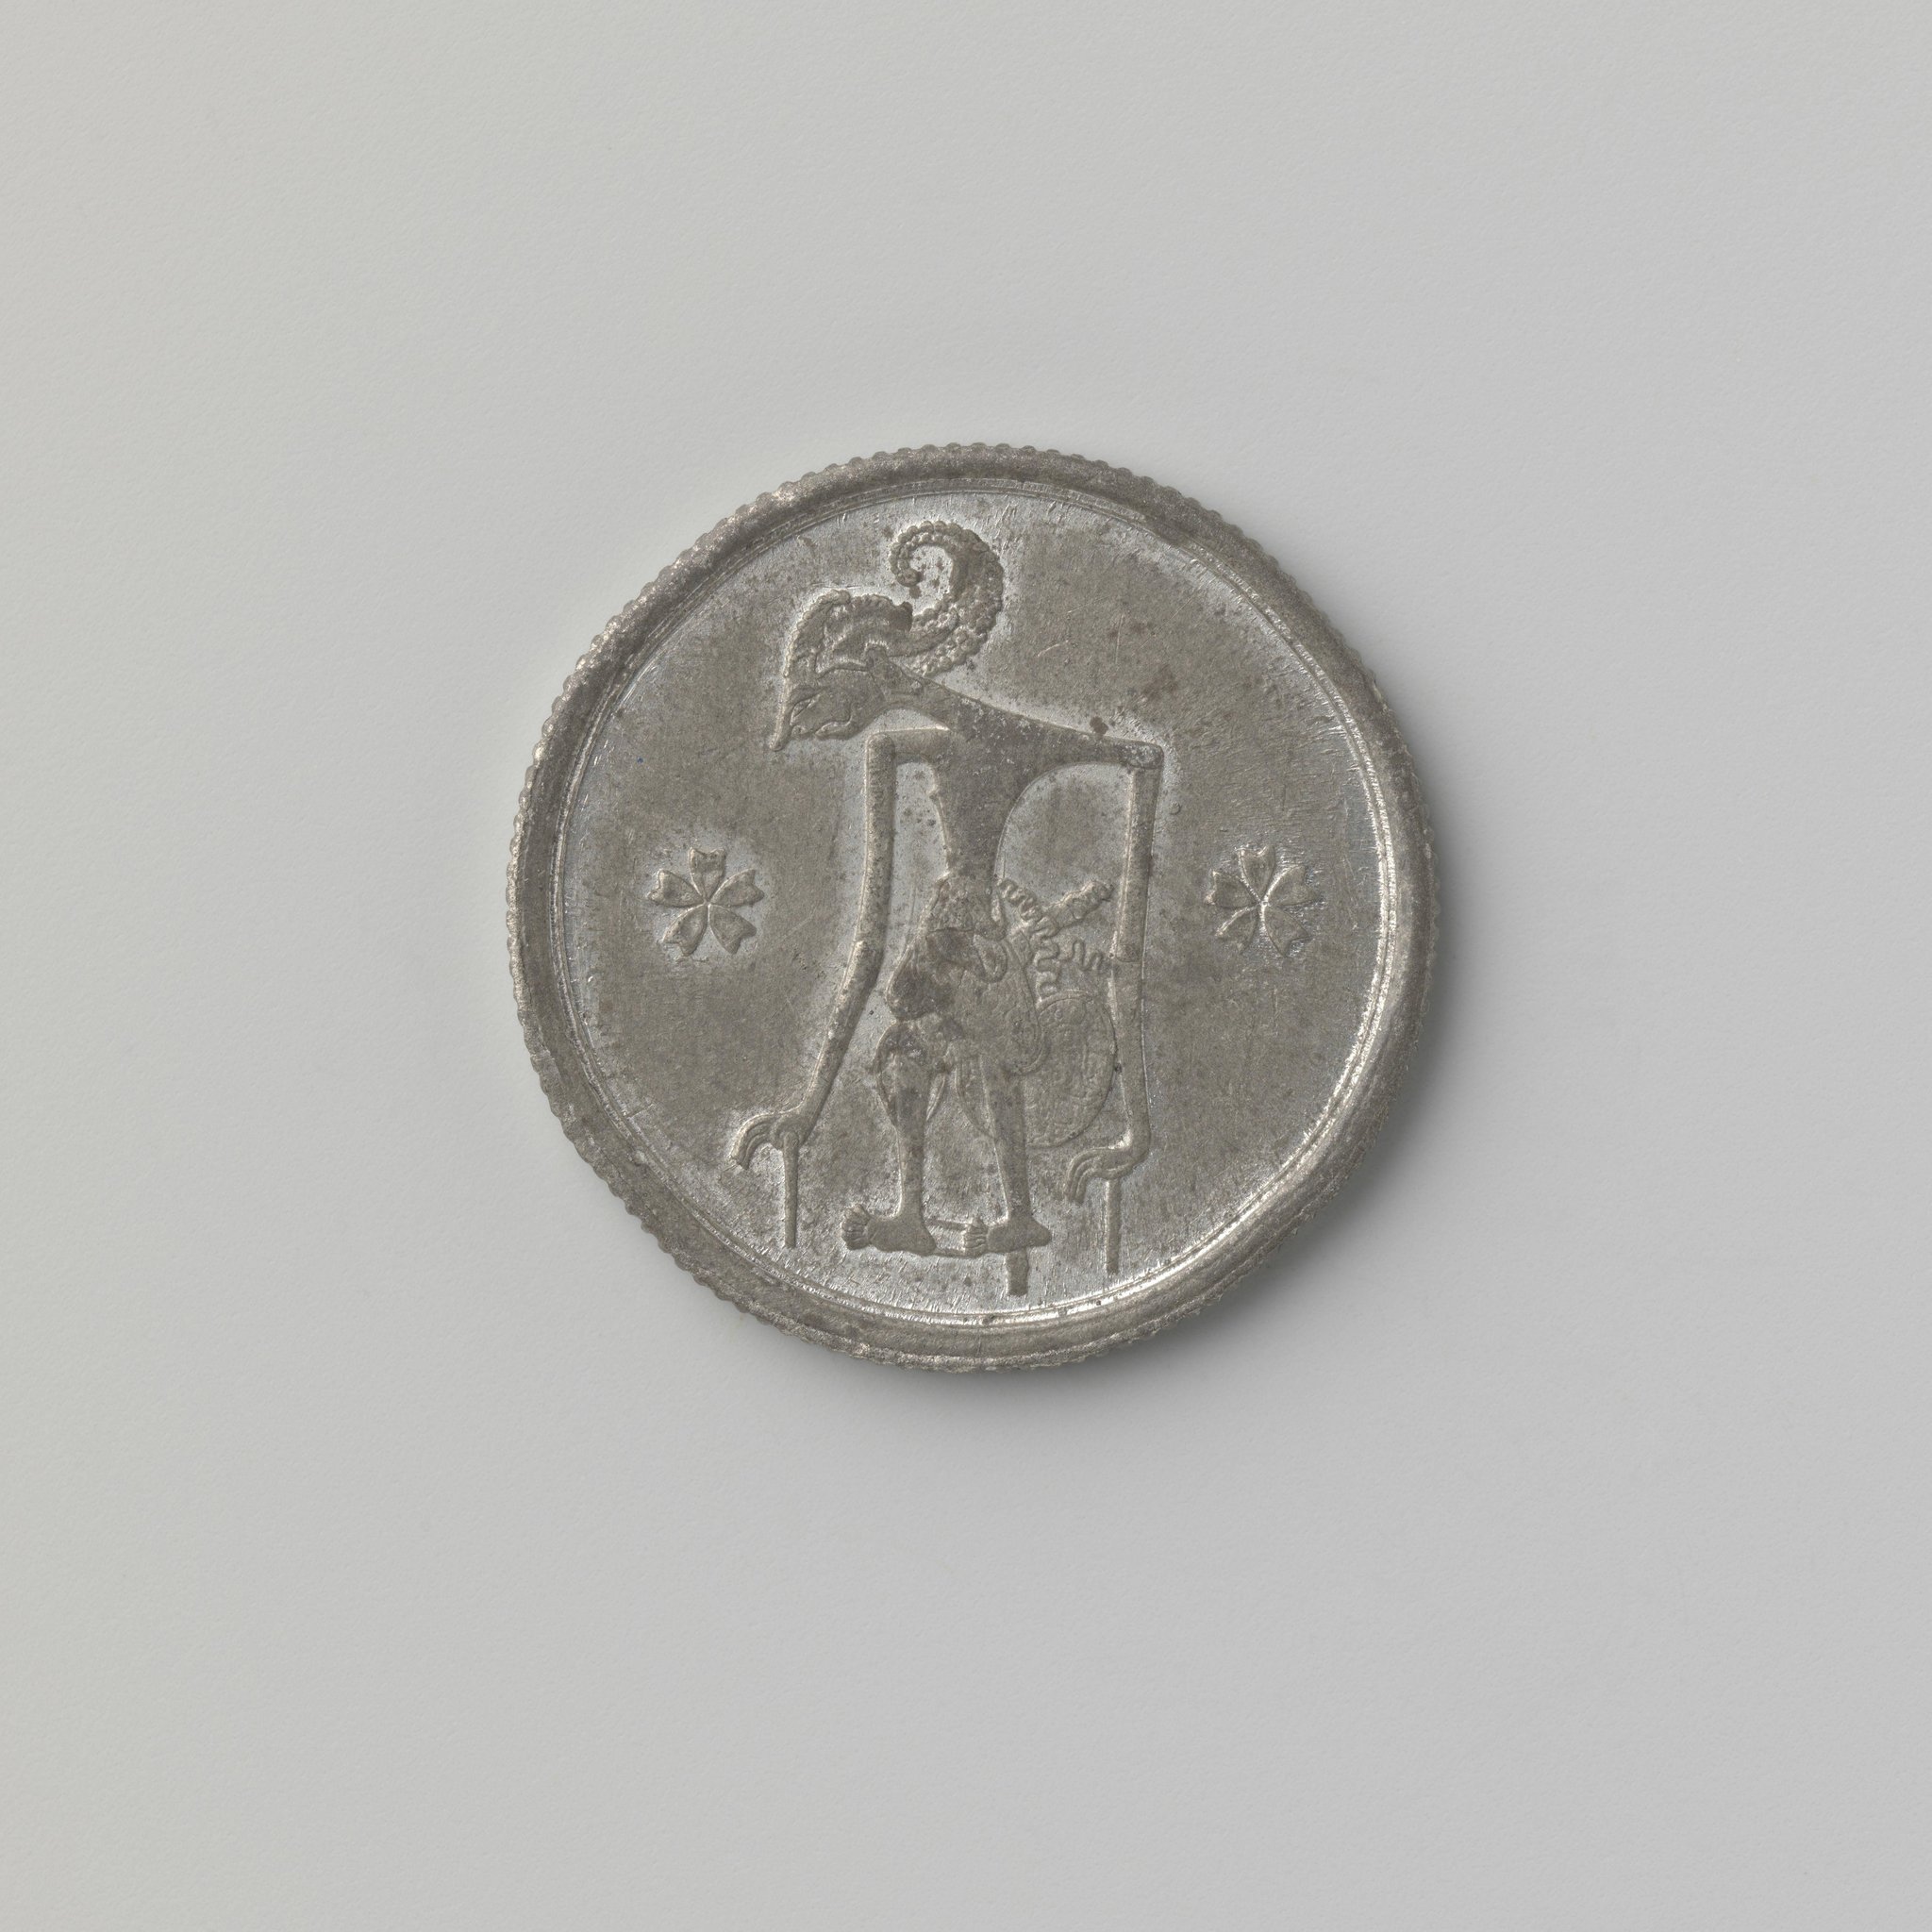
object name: tien sen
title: Munt van tien sen, door de Japanners geslagen tijdens de bezetting van Nederlands-Indië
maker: Anonymous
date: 1943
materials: tin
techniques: striking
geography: osaka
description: Munt met op de voorzijde de tekst ‘het grote Japan’, 10 (sen) en jaartal 2603 (=1943), op de keerzijde een wajangpop.